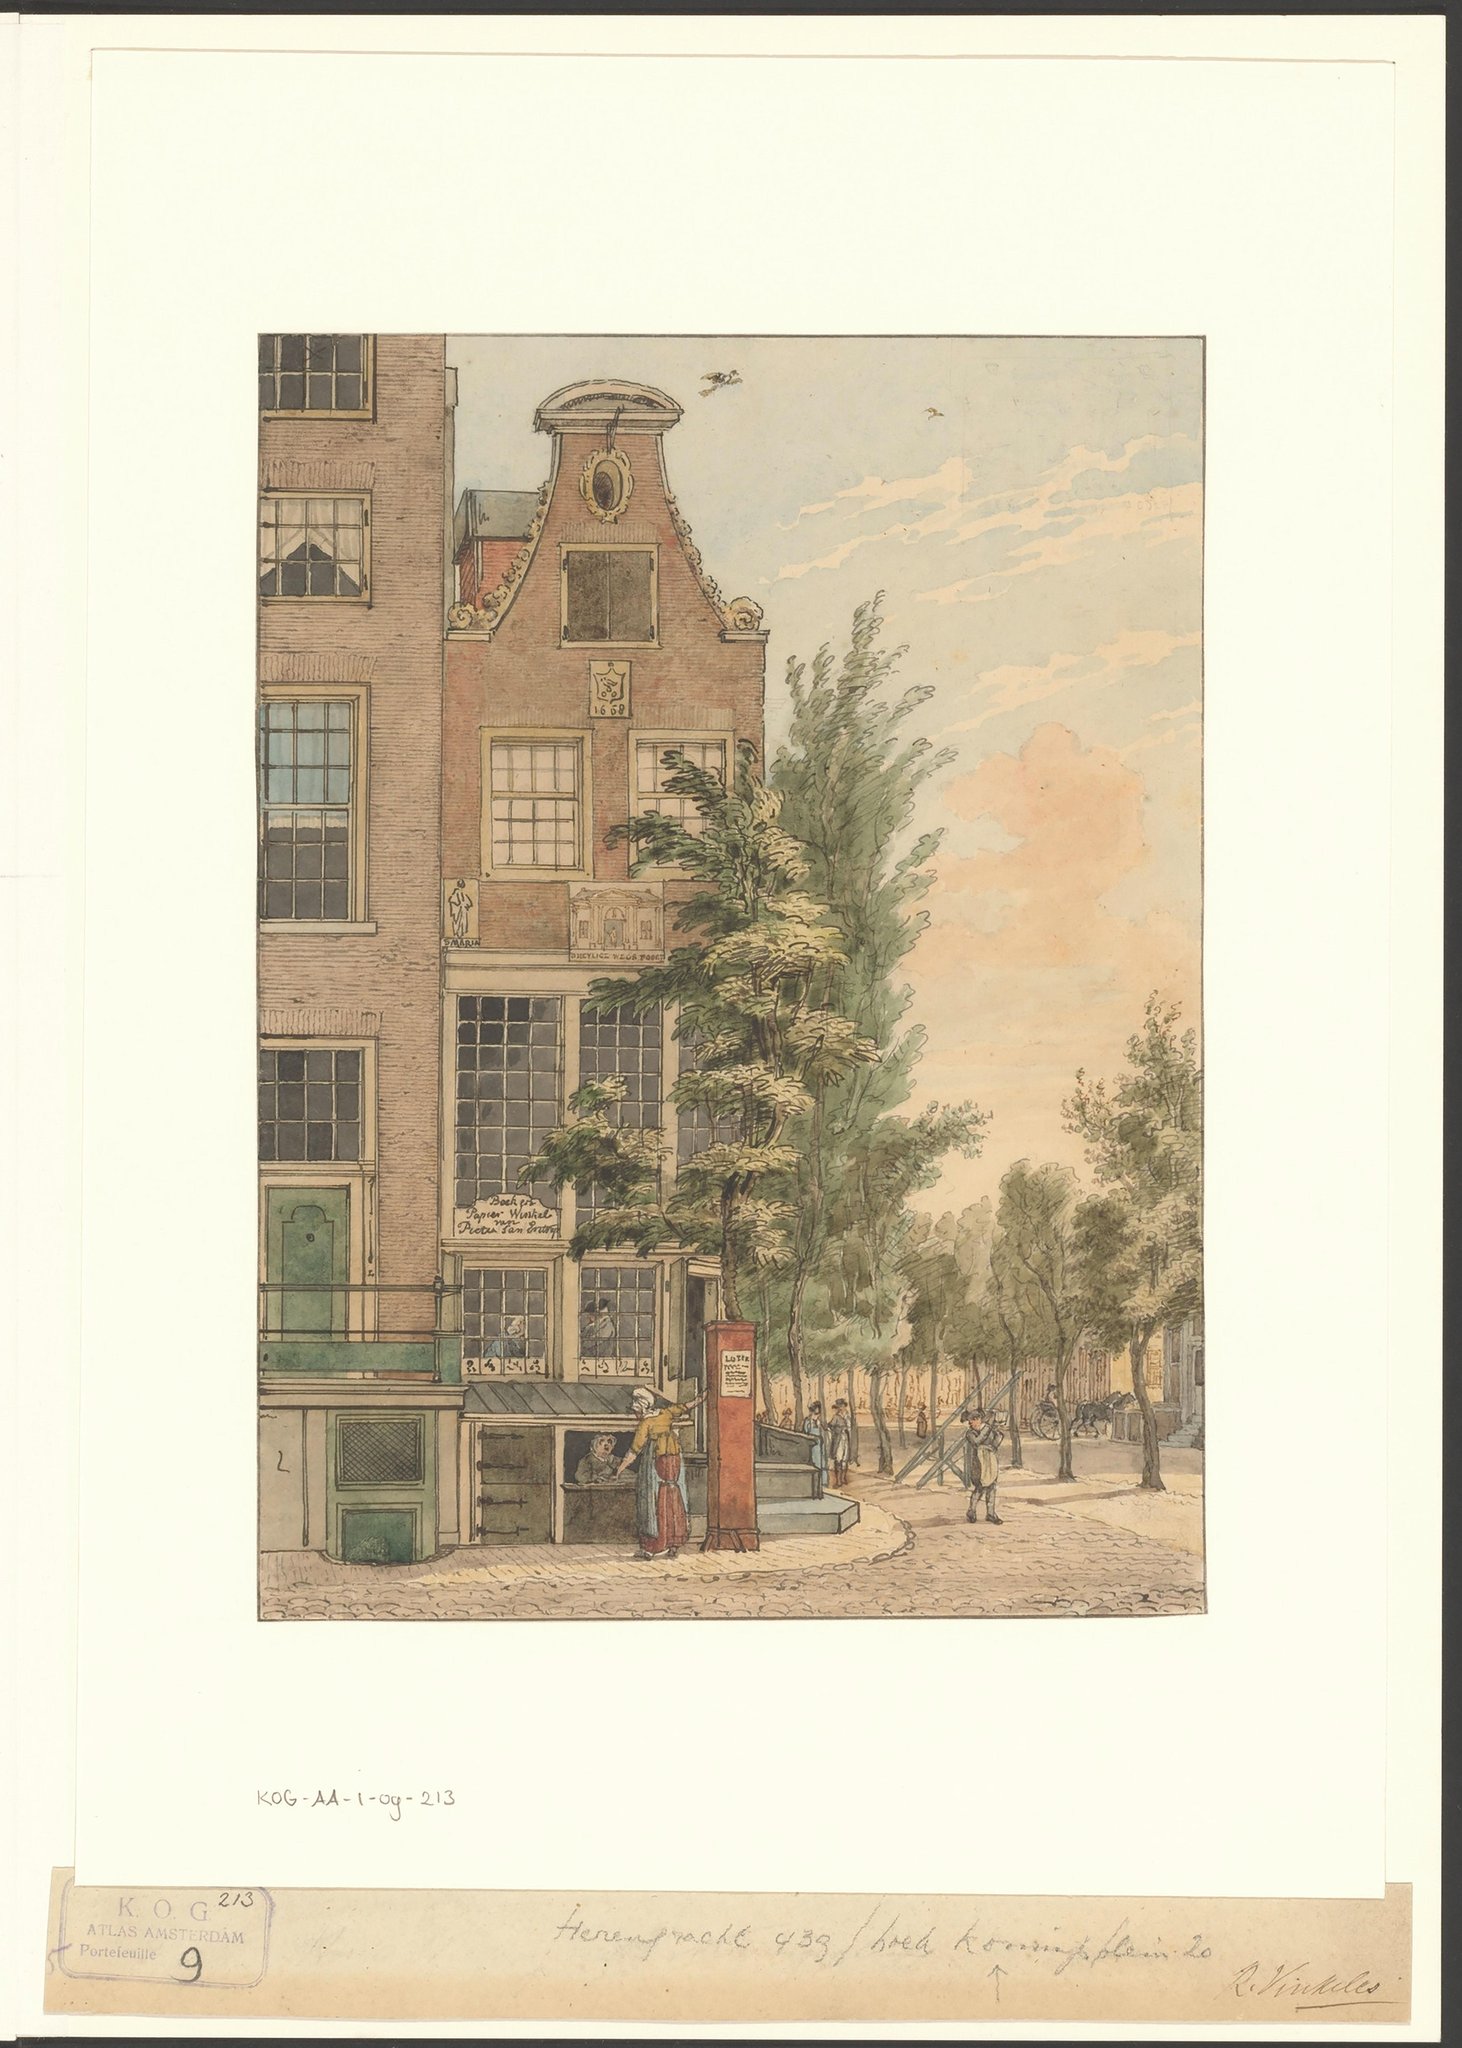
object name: drawing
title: Gezicht op Herengracht 439, hoek Koningsplein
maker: reinier vinkeles (i)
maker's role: draughtsman, print maker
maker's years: 1741-1816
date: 1769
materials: ink, paper, pencil, watercolor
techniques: brush, pen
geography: amsterdam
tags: city-view in general; 'veduta', façade (of house or building), street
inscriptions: inscription: ‘Pieter Jan Eutrop van 1762-1770 op adres / Herengracht hk. Koningsplein / uitgever van Vinkeles’, collector's mark: ‘9’ Lugt 1641b, inscription: ‘Port. 9-213’, signature, date and inscription: ‘R Vinkeles ad viv delin 1769. / [...] ziend van den W[...] Meer A Ve[...]eul’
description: Onderwerpsrubriek binnen de Atlas Amsterdam: Kadijksplein, Karthuizerkerkhof, Kattegat, Kattenburg, Kapelsteeg O.Z., Enge Kerksteeg, Kerkstraat, Kinkerstraat, Kolk O.Z., Koningsplein, Kromboomsloot [Krom Boomssloot], Kostverlorenkade, Kwakersdwarspad, Kalverstraat, Keizersgracht (v.d. Brouwersgracht – Amstel), Klerensloot (Gedempte), Klimopstraat, Kloveniersburgwal, Kraansluis.